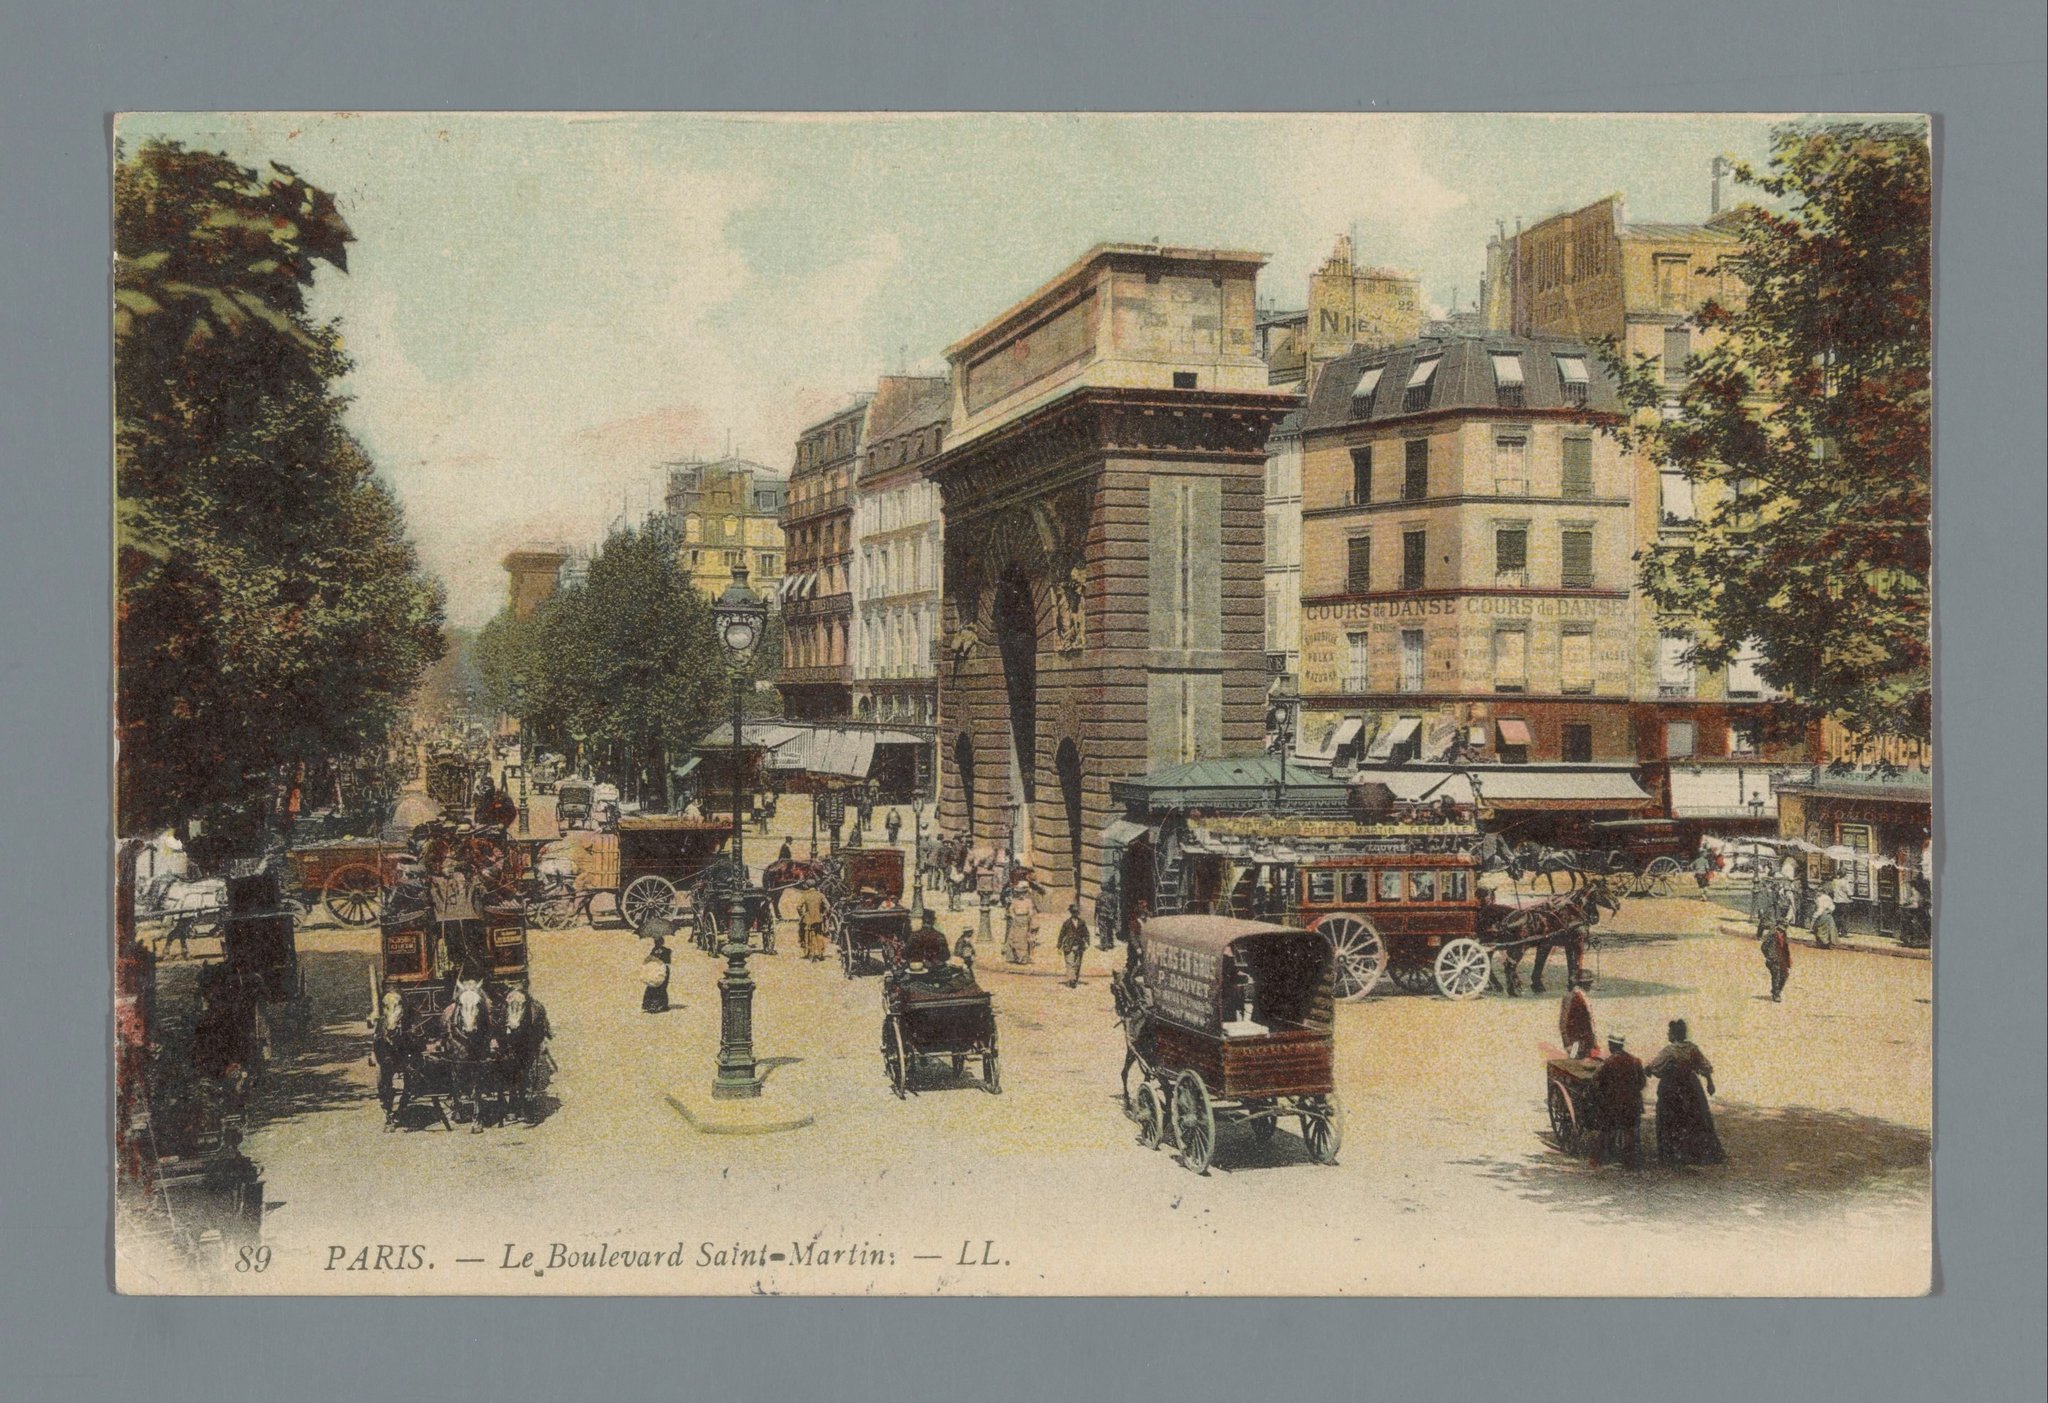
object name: ansichtkaart, prentbriefkaart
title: Paris. - Le Boulevard Saint-Martin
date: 1908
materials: paper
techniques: photograph, writing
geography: boulevard saint-martin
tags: city-view in general; 'veduta', triumphal arch, street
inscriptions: number: ‘89’